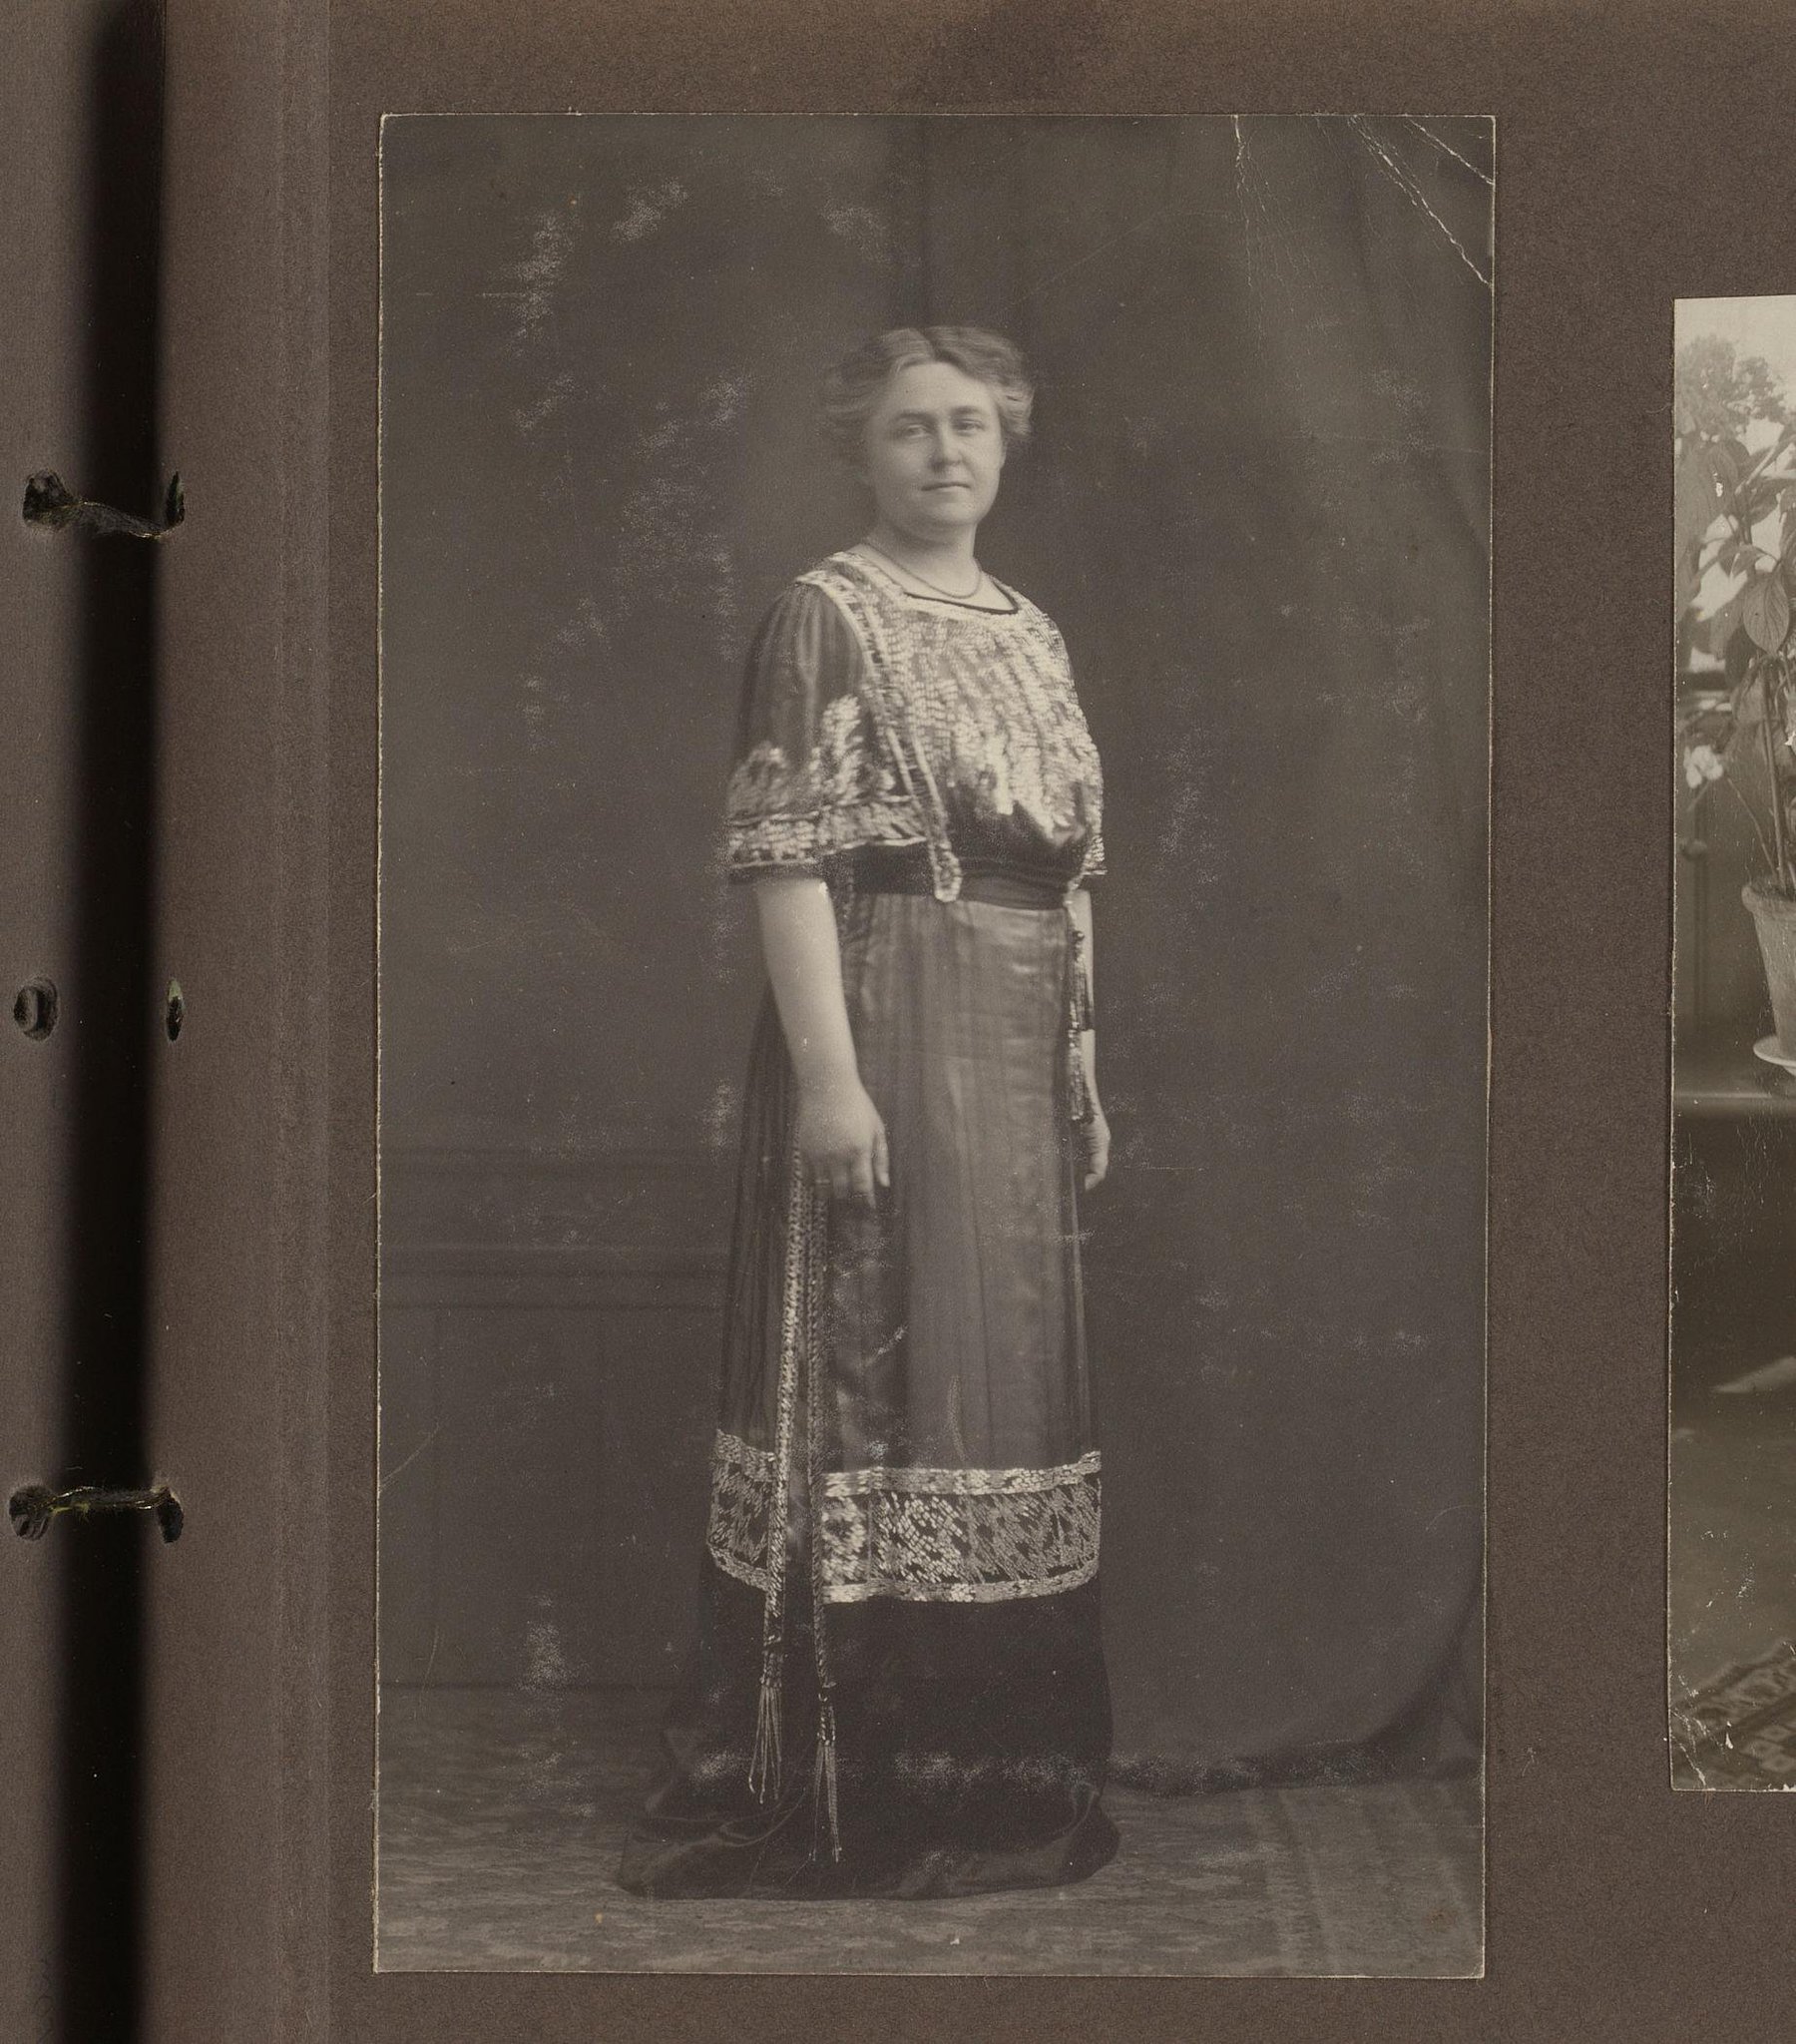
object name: photograph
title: Portret van een staande vrouw in een avondjurk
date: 1905-1915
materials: paper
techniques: gelatin silver print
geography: netherlands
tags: dress, gown: ball gown, anonymous historical person portrayed alone - bb - woman